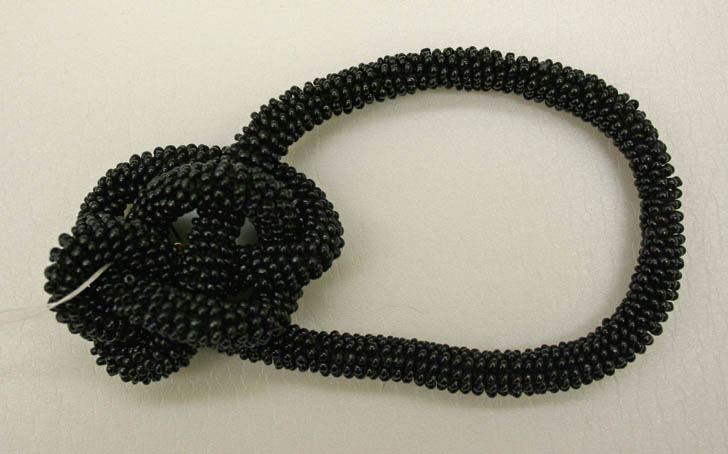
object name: bracelet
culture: american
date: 1834-1866